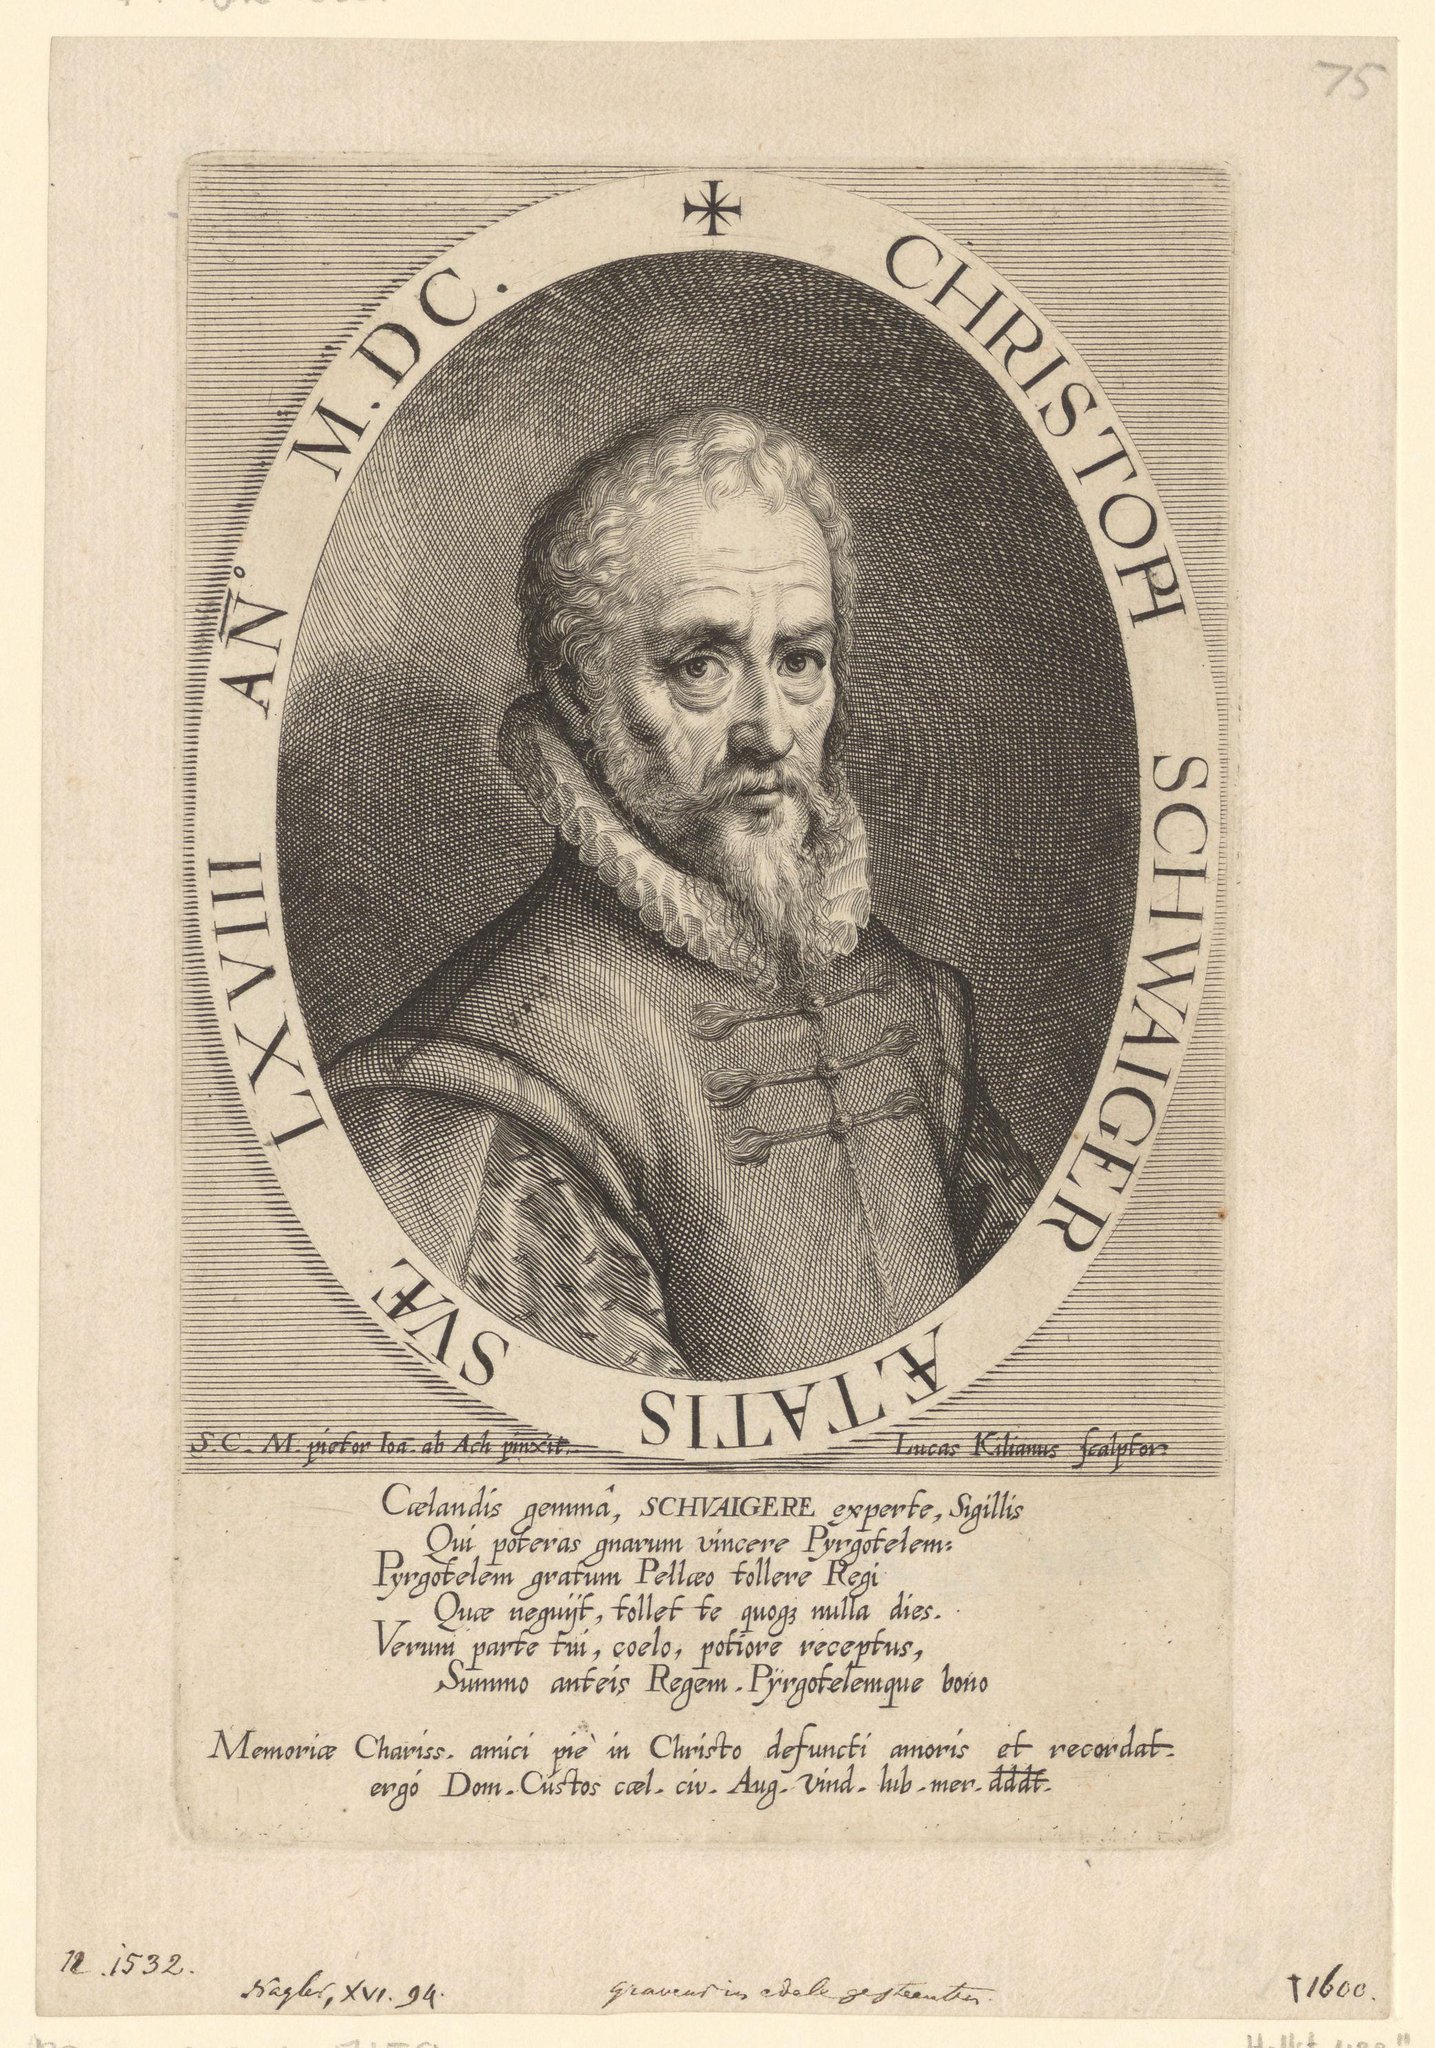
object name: print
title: Portret van Christoph Schwaiger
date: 1600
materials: paper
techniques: engraving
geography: augsburg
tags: christoph schwaiger, historical persons, jeweller, goldsmith, silversmith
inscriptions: collector's mark: Lugt 2228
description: Tekst in het Latijn in de omlijsting en in de ondermarge.